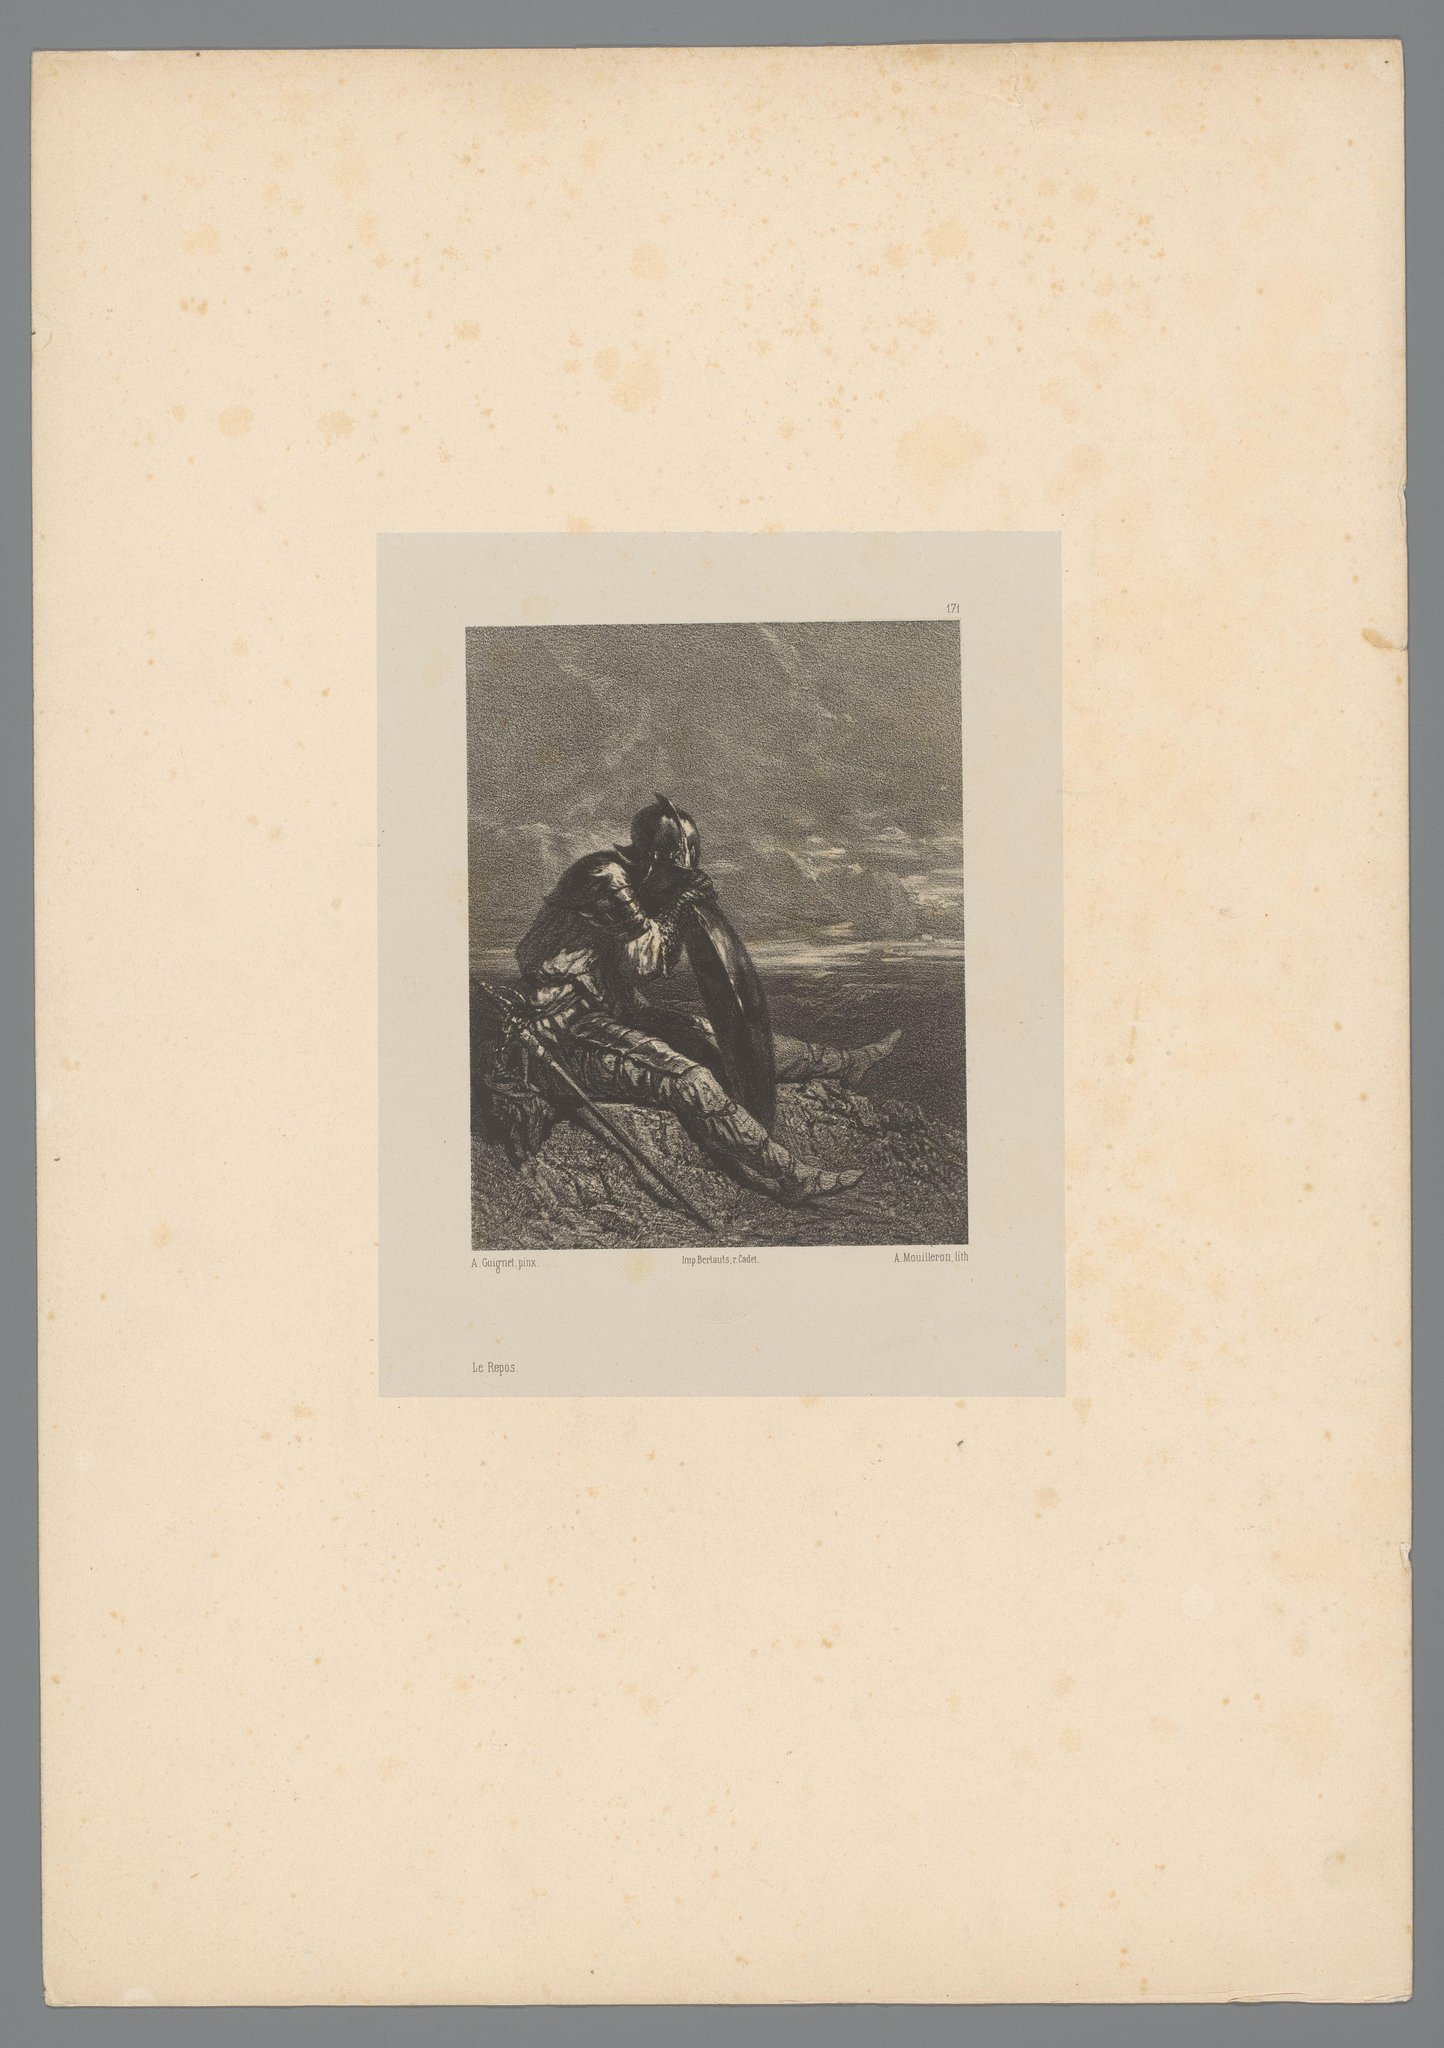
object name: print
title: Le repos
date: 1851-1862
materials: paper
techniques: lithograph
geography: paris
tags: rock-formations - hh - ideal landscapes, the soldier; the soldier's life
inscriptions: check stamp: Lugt 36a, inscription: ‘Aug Allebé’, collector's mark: Lugt 2233